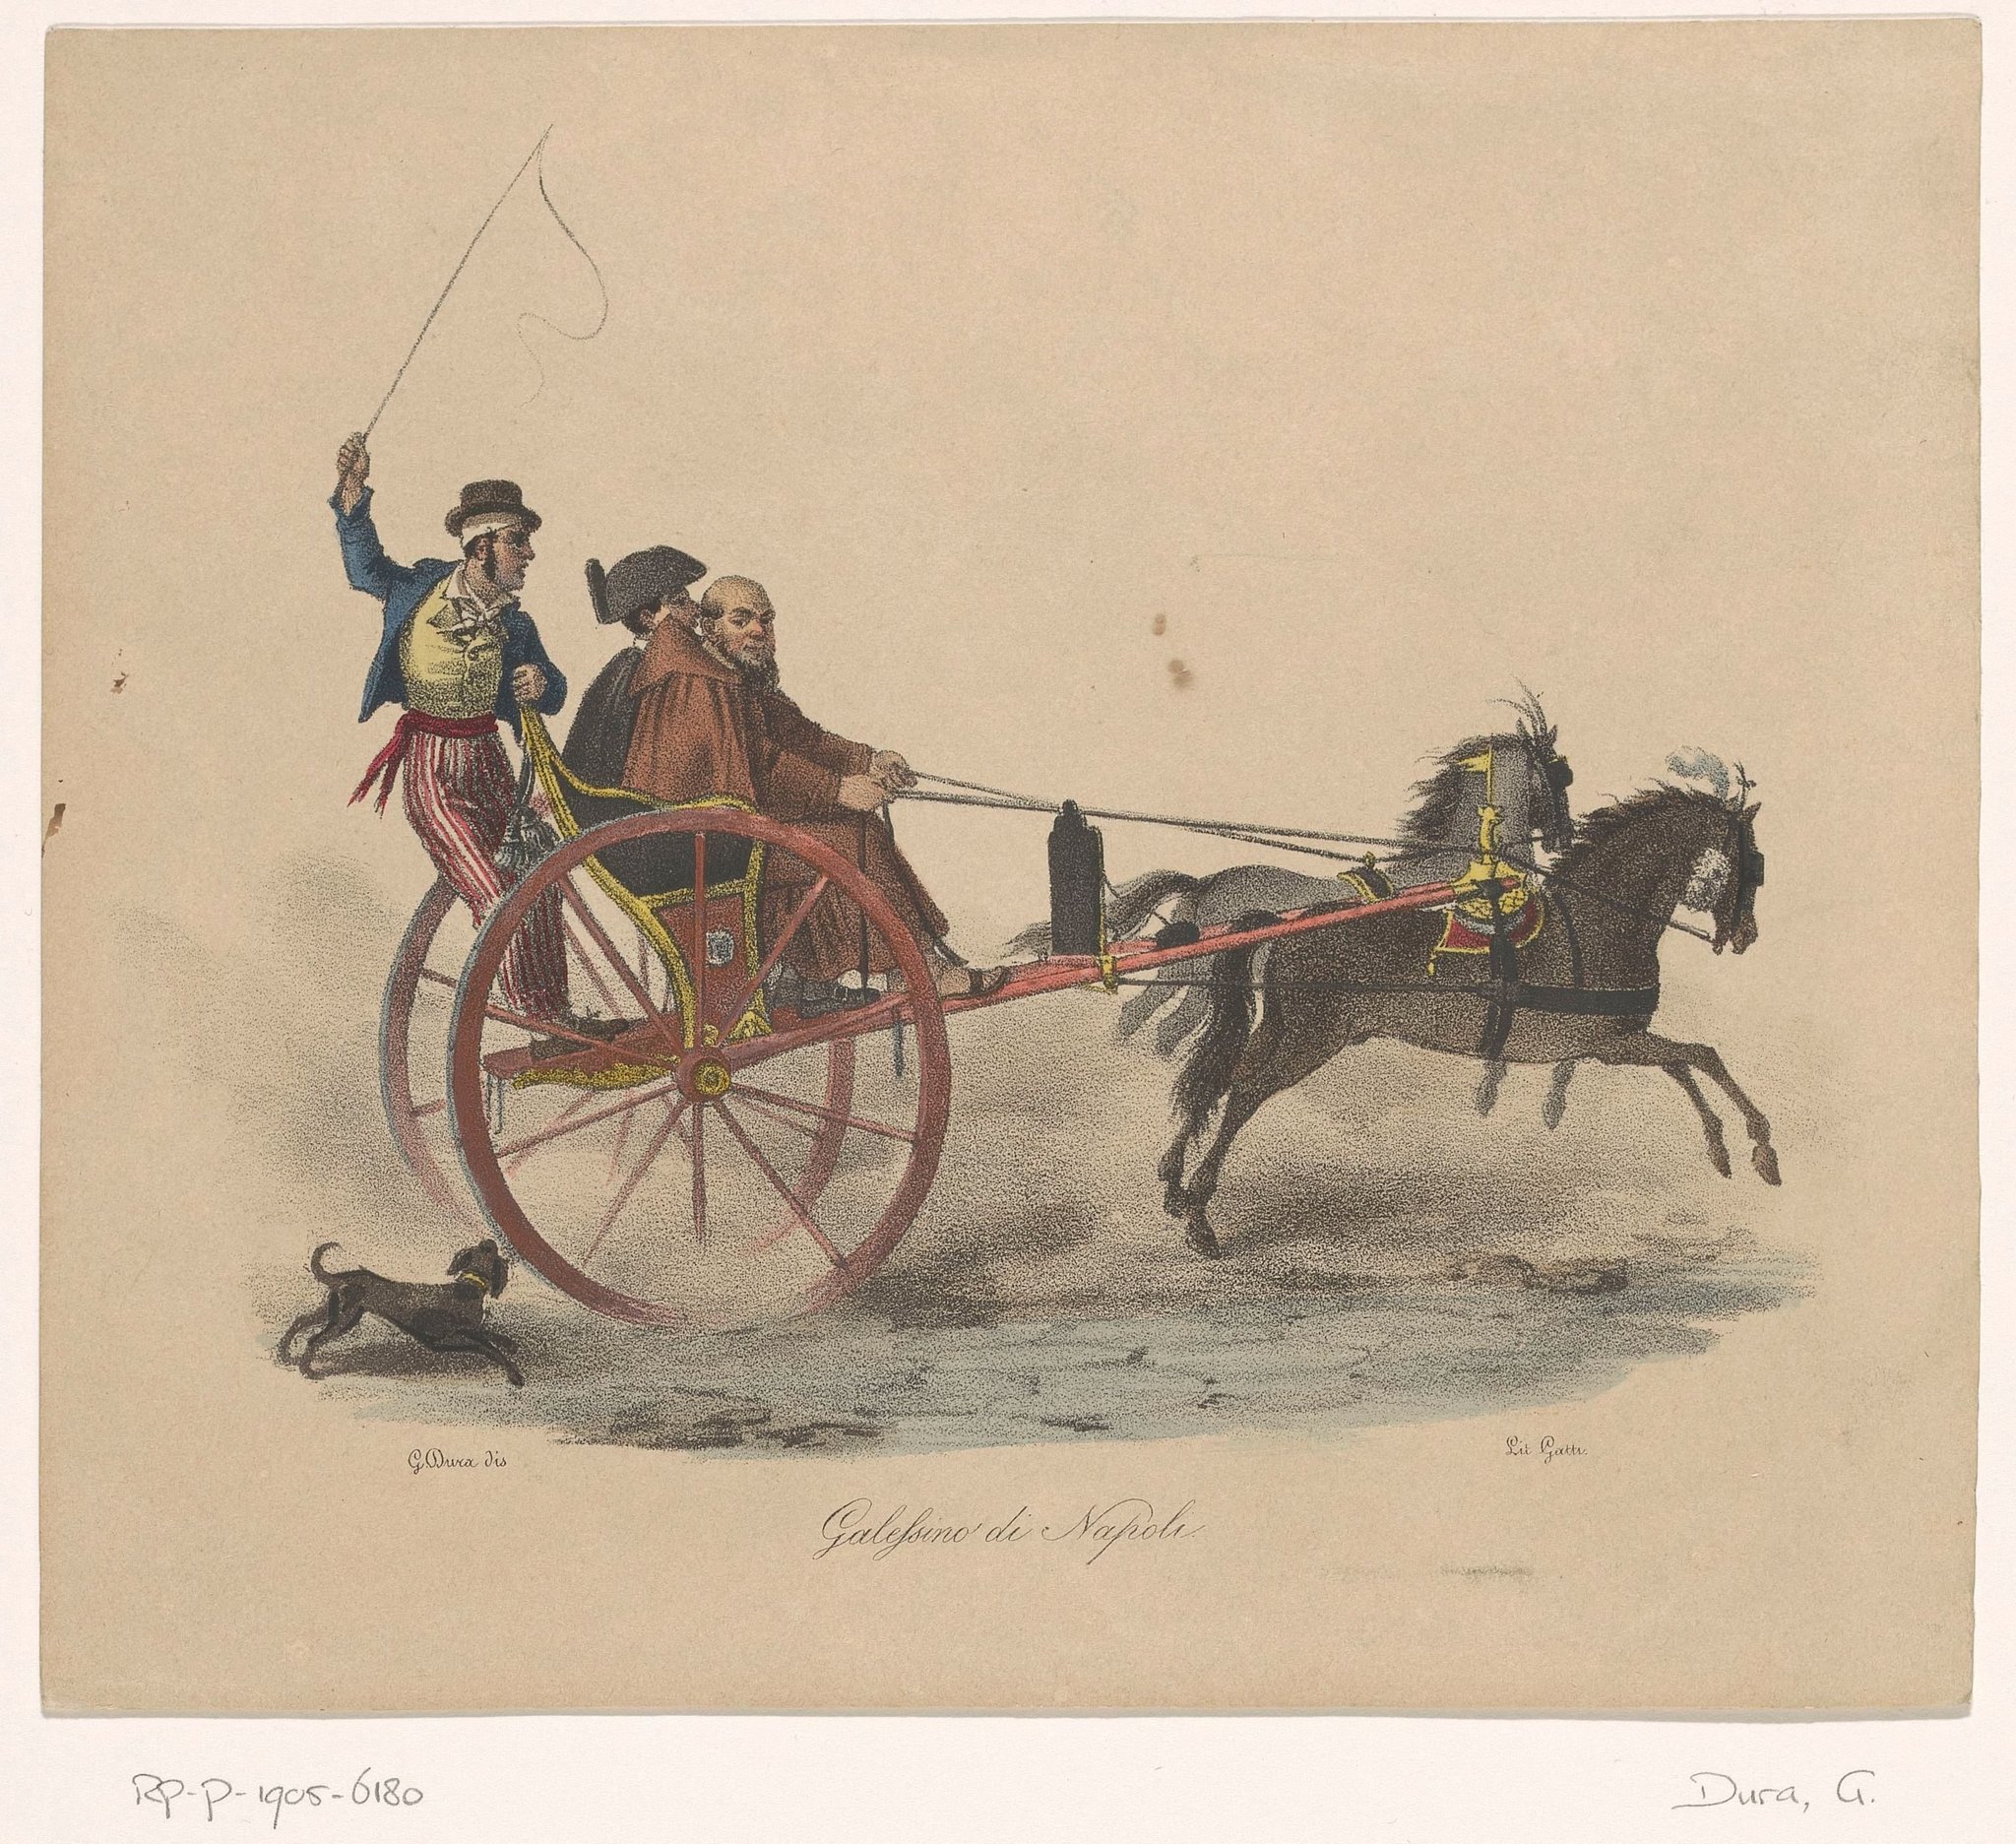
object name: print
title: Drie mannen in een rijtuig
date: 1815-1878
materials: paper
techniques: hand coloring, lithograph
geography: italy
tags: monk(s), friar(s), two-wheeled vehicle drawn by two animals, naples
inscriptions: collector's mark: Lugt 2228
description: Drie mannen, waaronder een monnik, in een rijtuig dat wordt voortgetrokken door twee paarden, te Napels. Naast het rijtuig rent een hond.